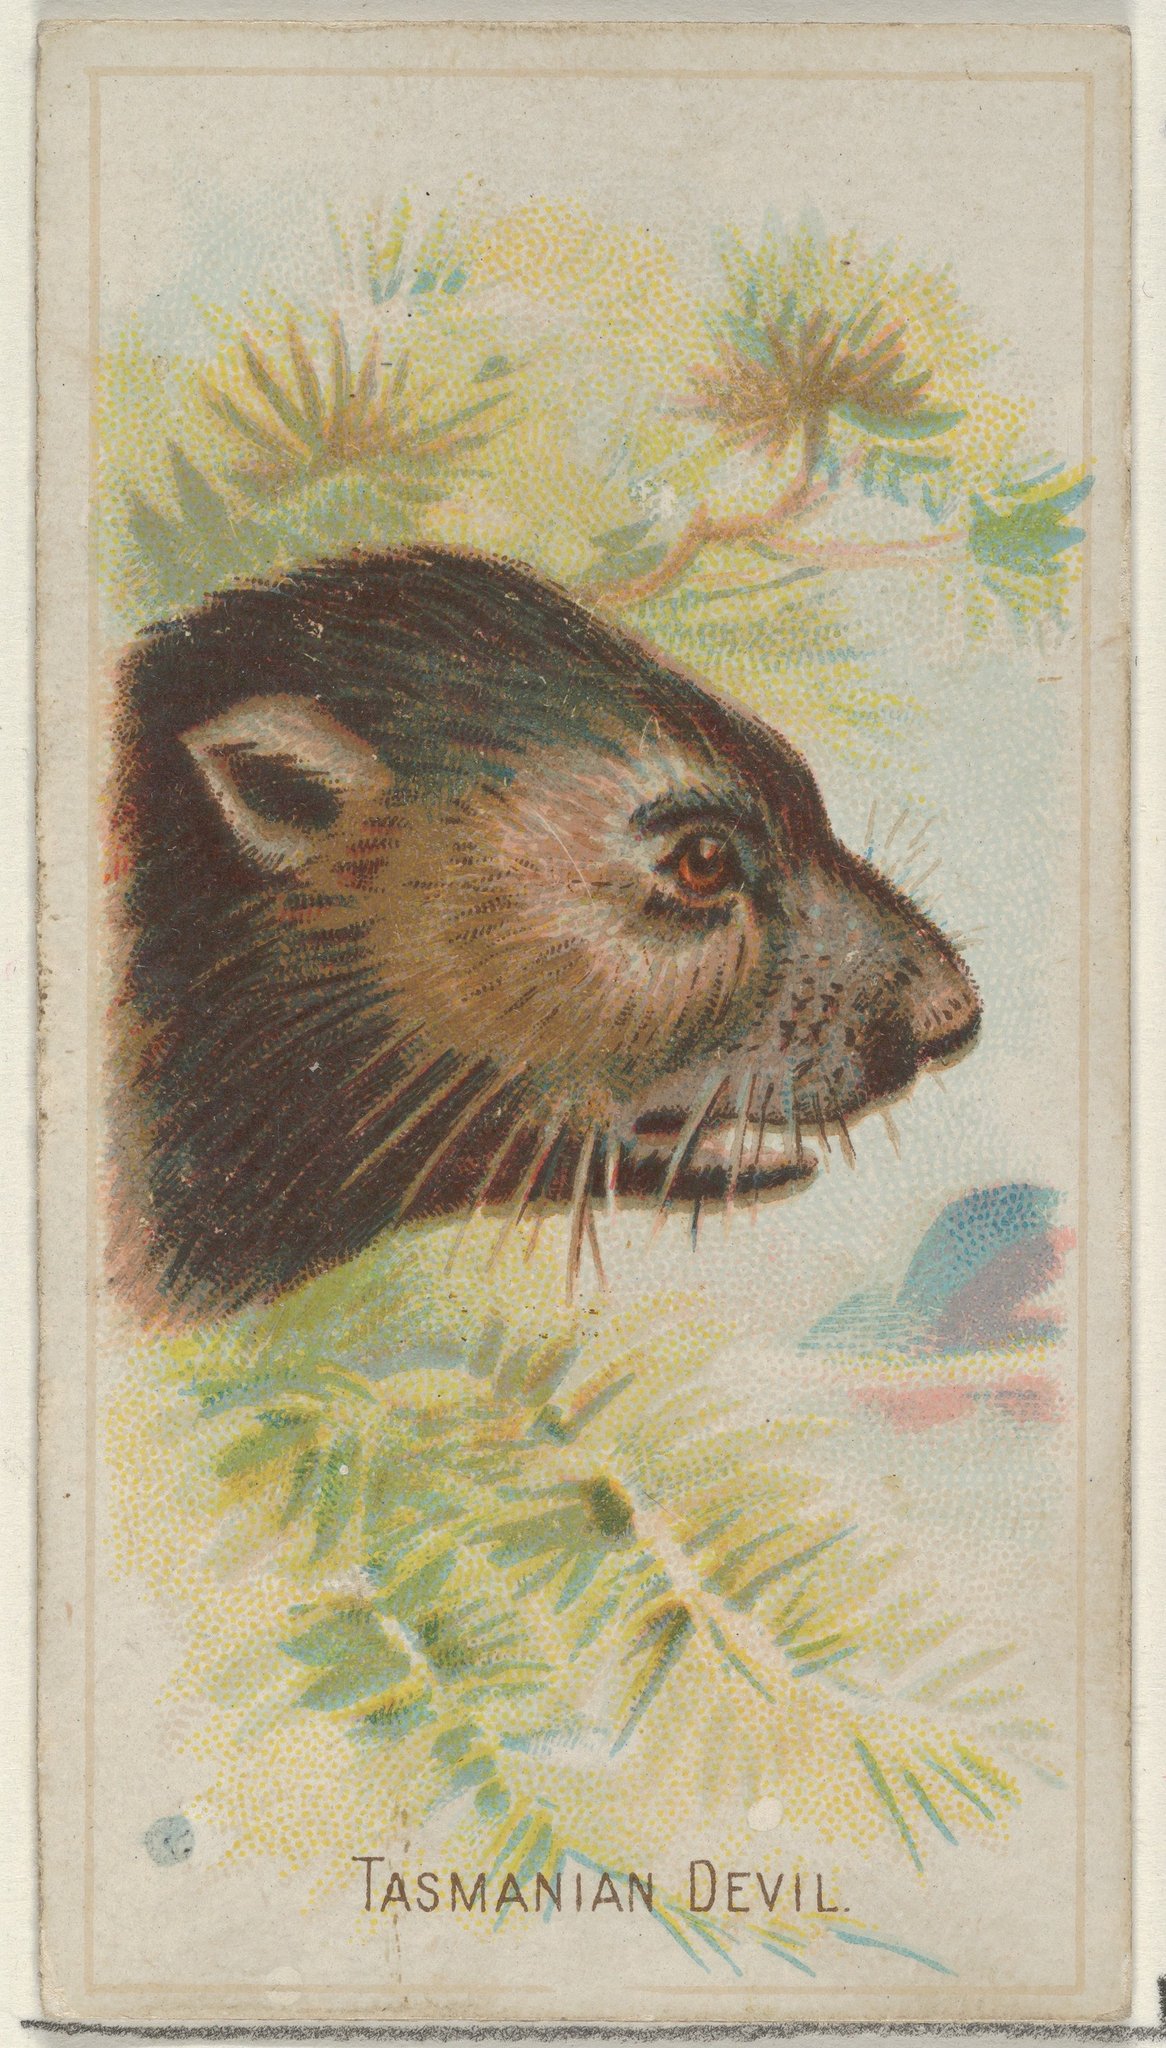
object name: print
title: Tasmanian Devil, from the Wild Animals of the World series (N25) for Allen & Ginter Cigarettes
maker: allen & ginter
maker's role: publisher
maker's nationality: american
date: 1888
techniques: color lithograph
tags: animals